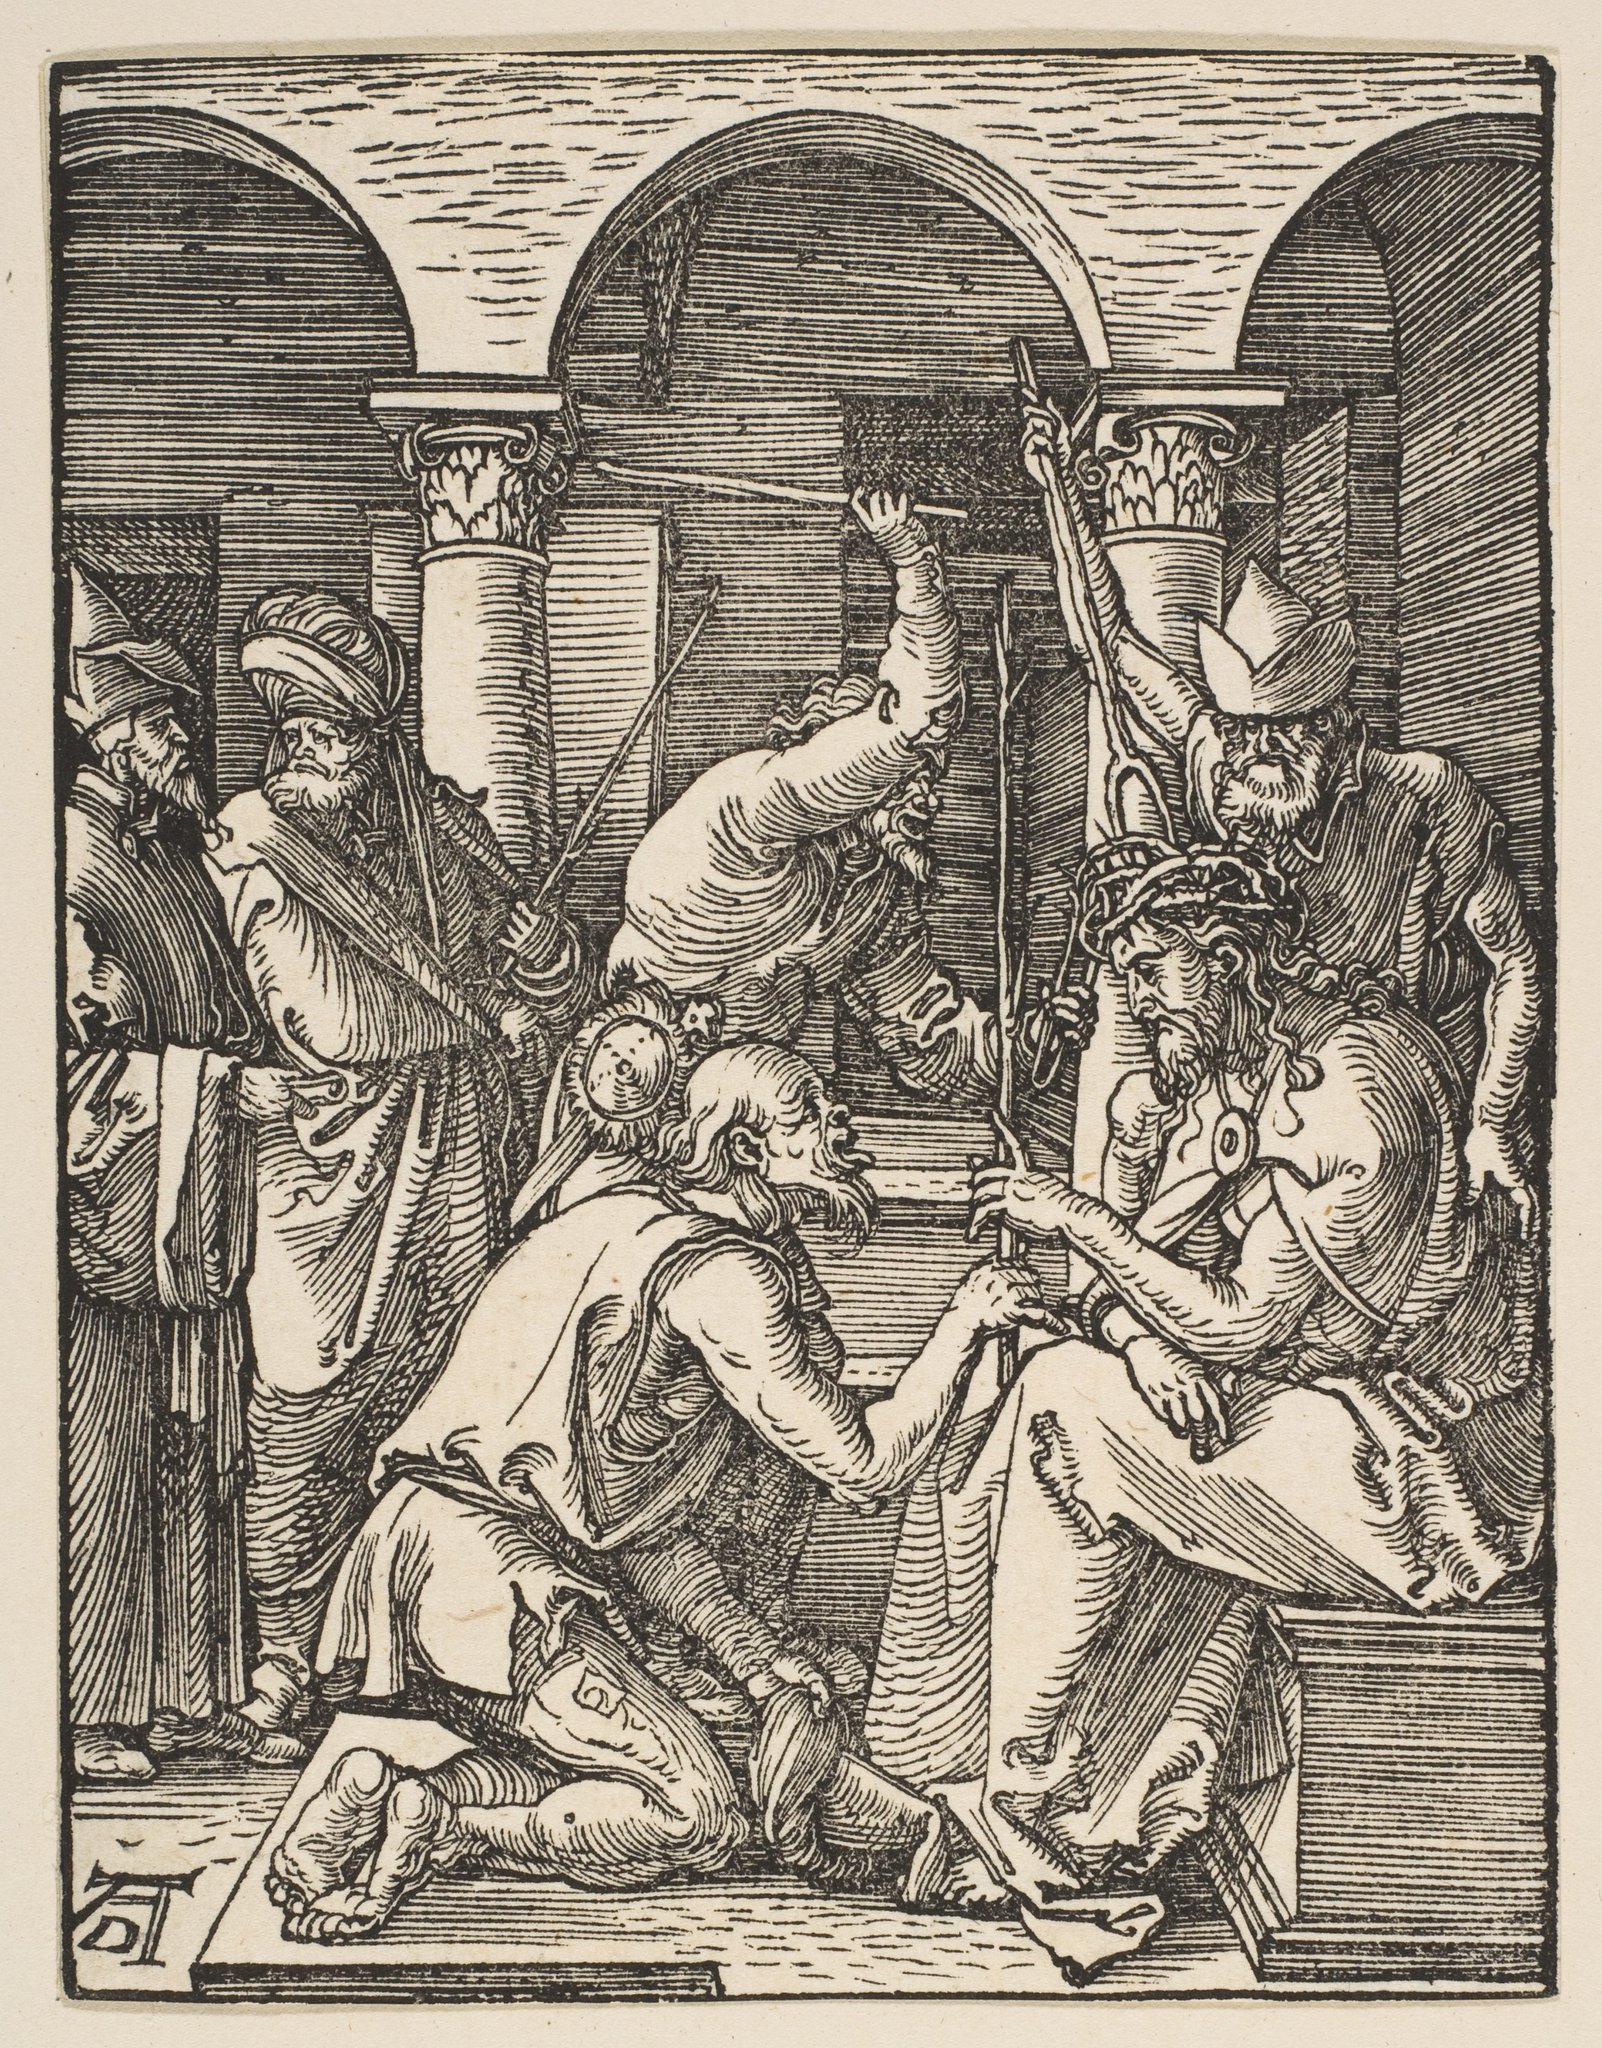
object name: print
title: Christ Crowned with Thorns, from "The Small Passion"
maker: albrecht dürer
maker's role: artist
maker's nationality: german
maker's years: 1471-1528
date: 1509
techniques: woodcut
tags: men,christ,punishment